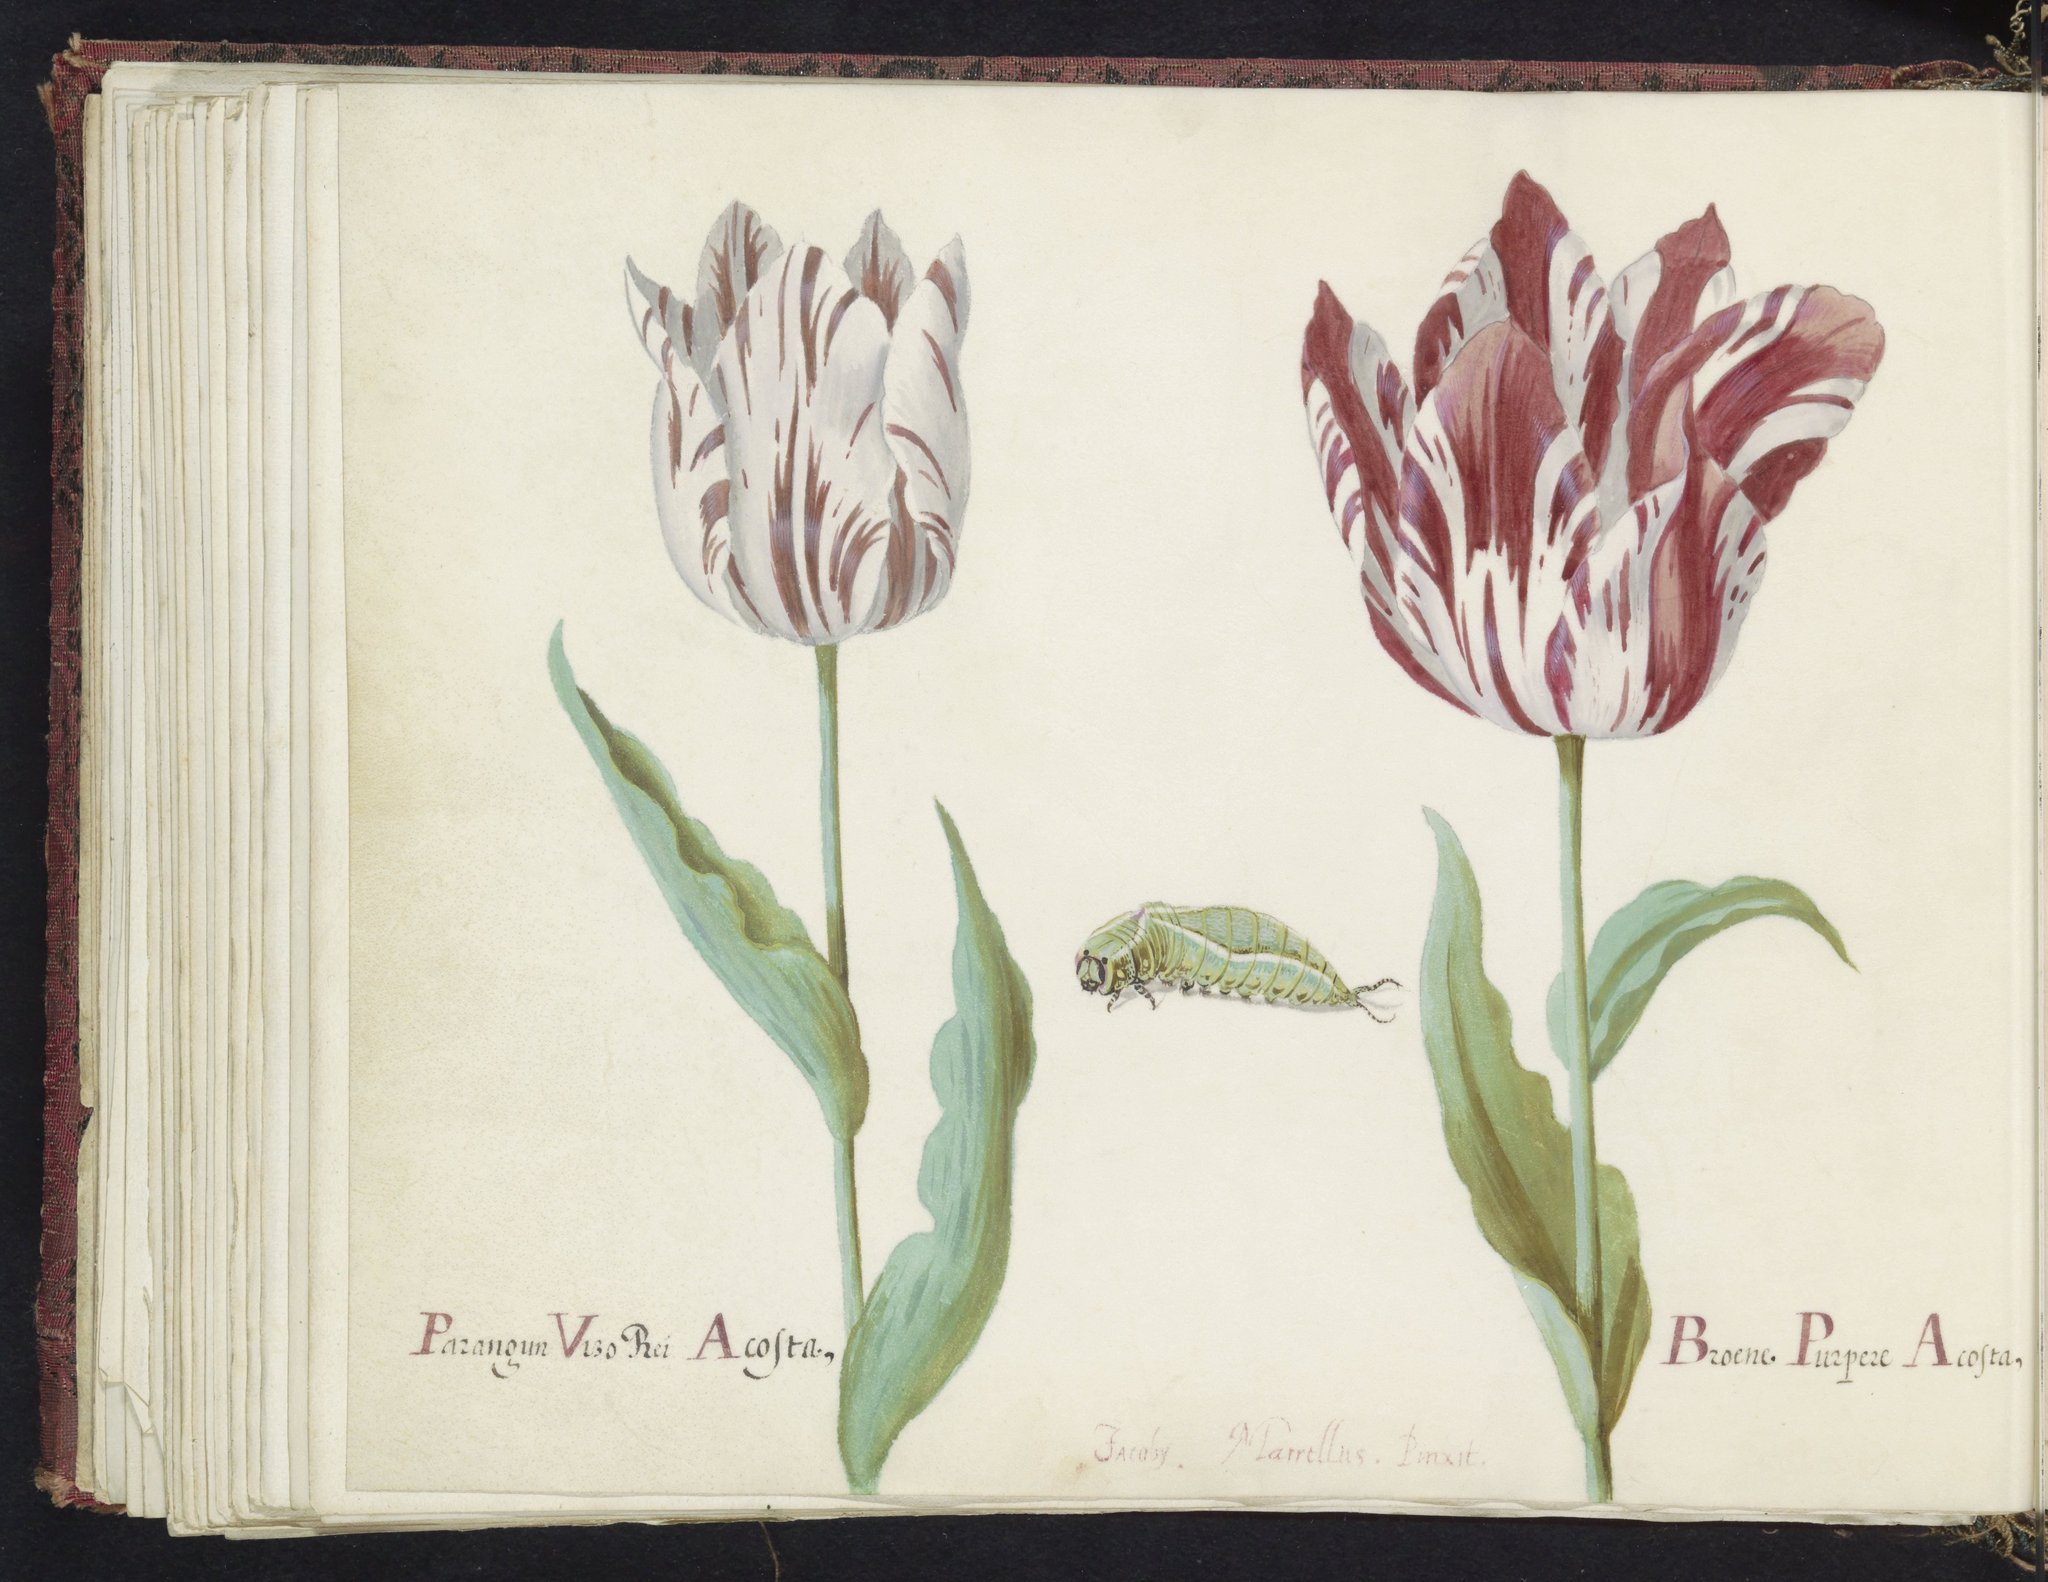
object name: album leaf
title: Parangun Vizo Rei Acosta / Broene Purper Acosta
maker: jacob marrel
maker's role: draughtsman, painter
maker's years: 1614-1681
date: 1637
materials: paint, parchment, pencil, watercolor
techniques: brush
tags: insects: butterfly, flowers: tulip, insects: caterpillar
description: De tekening maakt deel uit van een album.